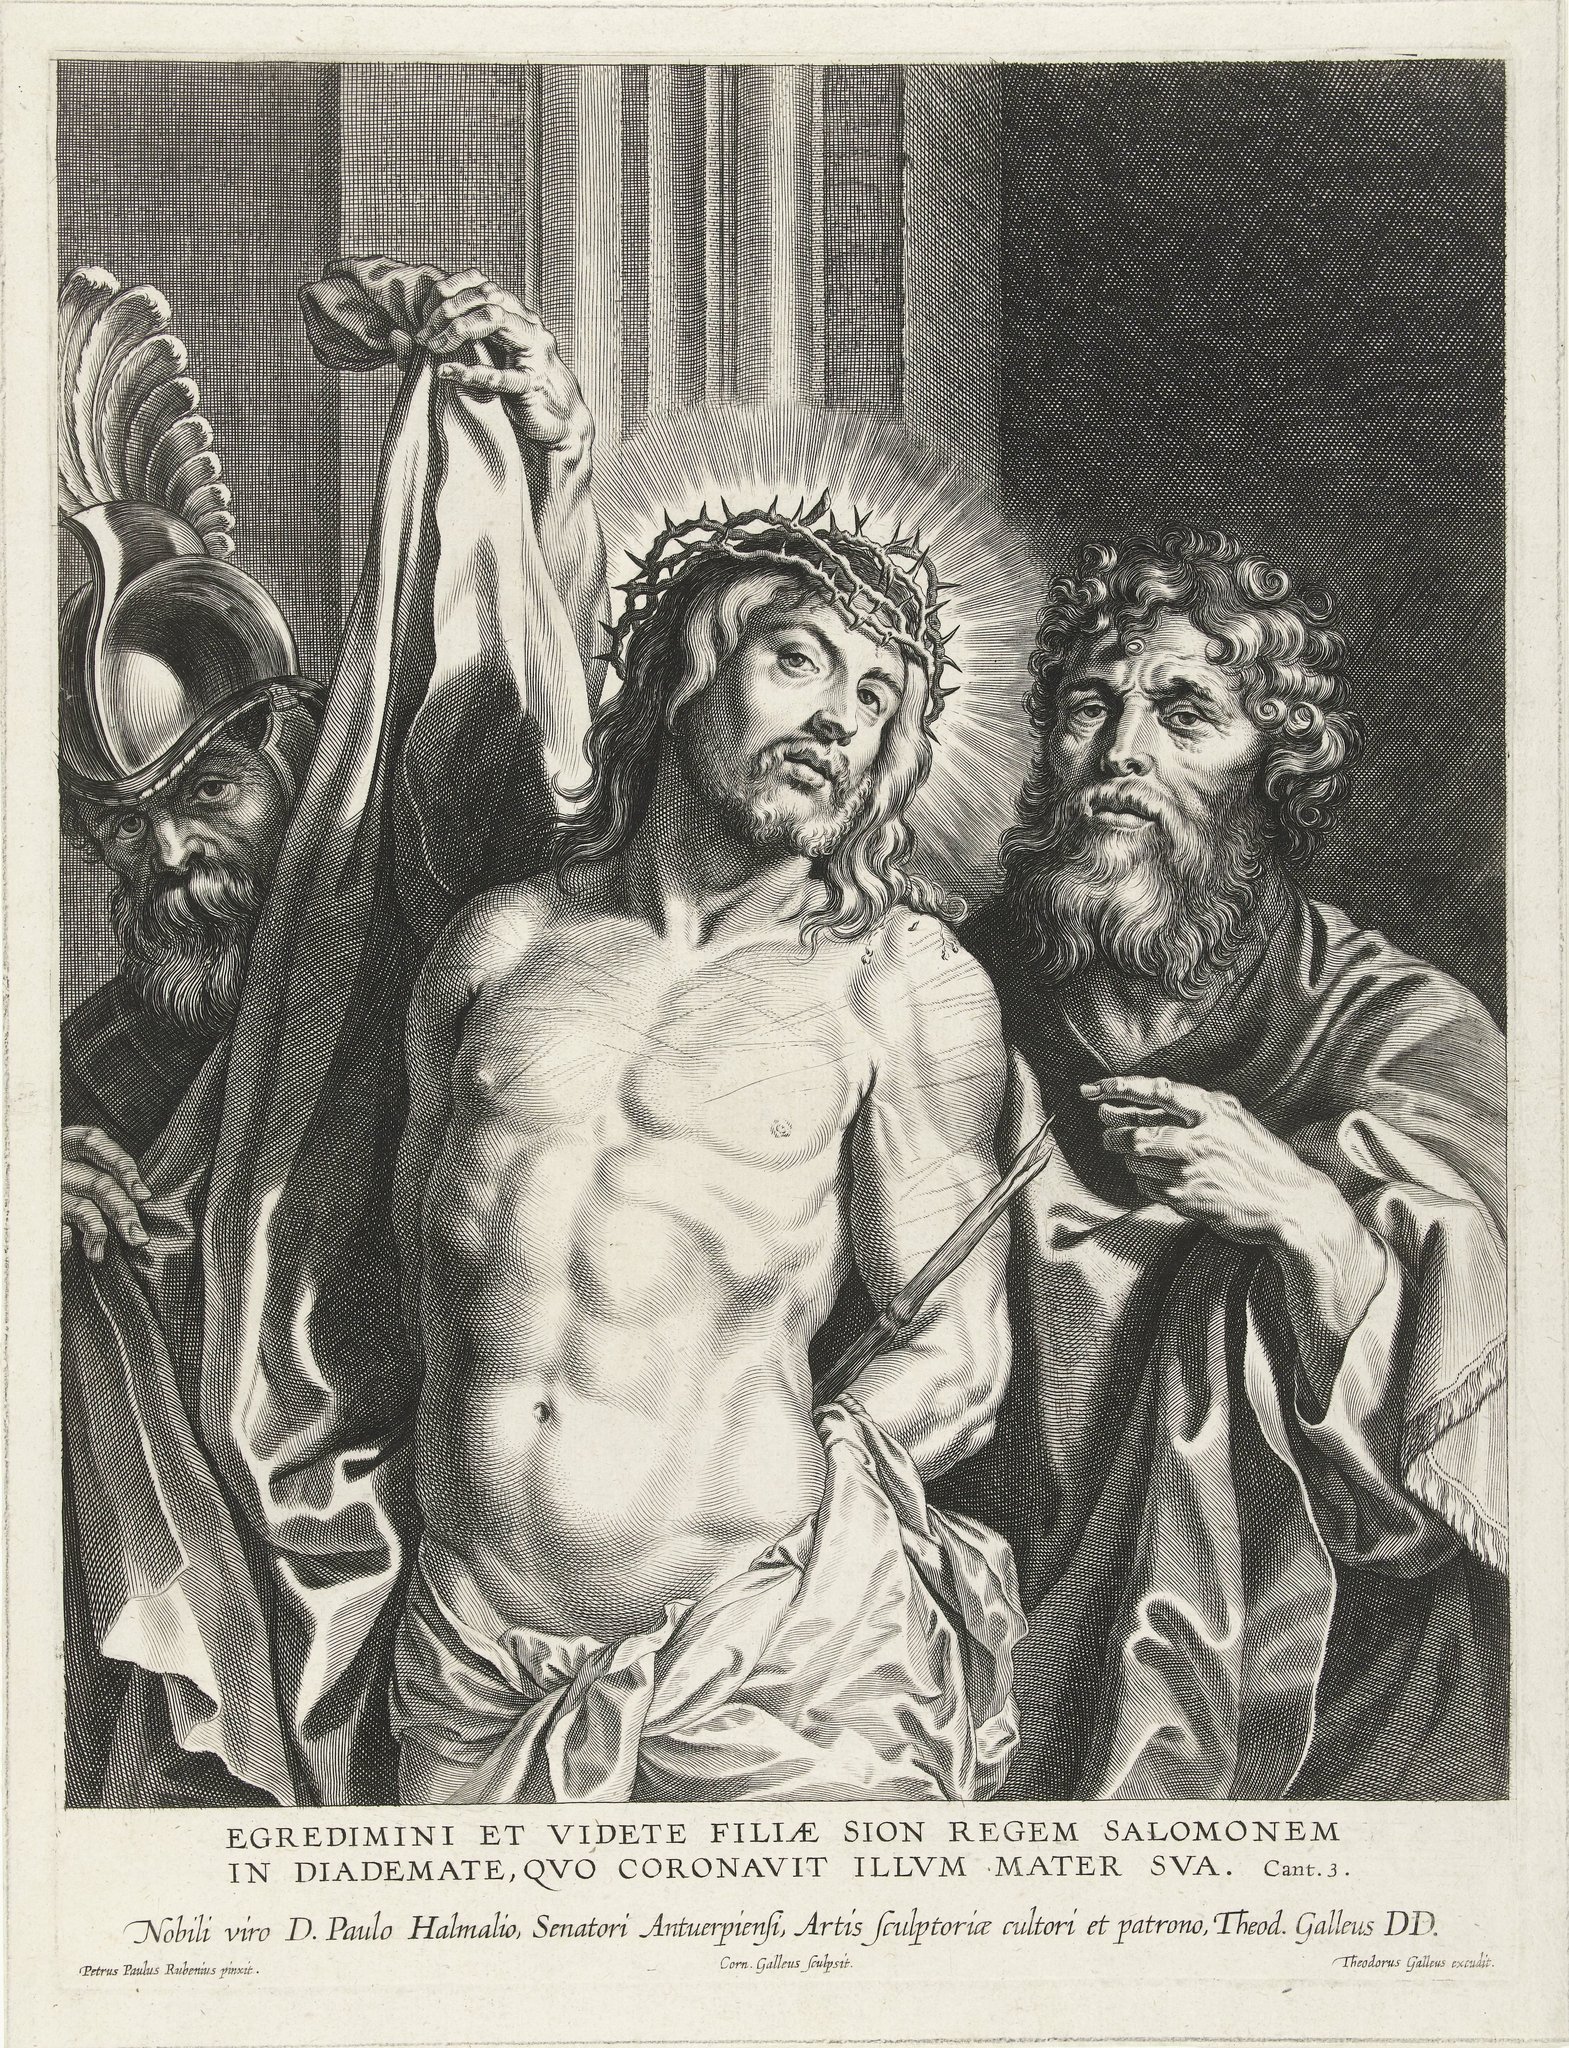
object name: print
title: Christus aan het volk getoond (Ecce Homo)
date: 1586-1633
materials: paper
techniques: engraving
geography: antwerp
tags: pilate showing christ to the people, 'ostentatio christi', 'ecce homo' (john 19:4-6)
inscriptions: collector's mark: Lugt 240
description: Christus met de doornenkroon wordt door twee soldaten aan het volk getoond. Onder de voorstelling een Latijns bijbelvers uit Hoogl. 3.